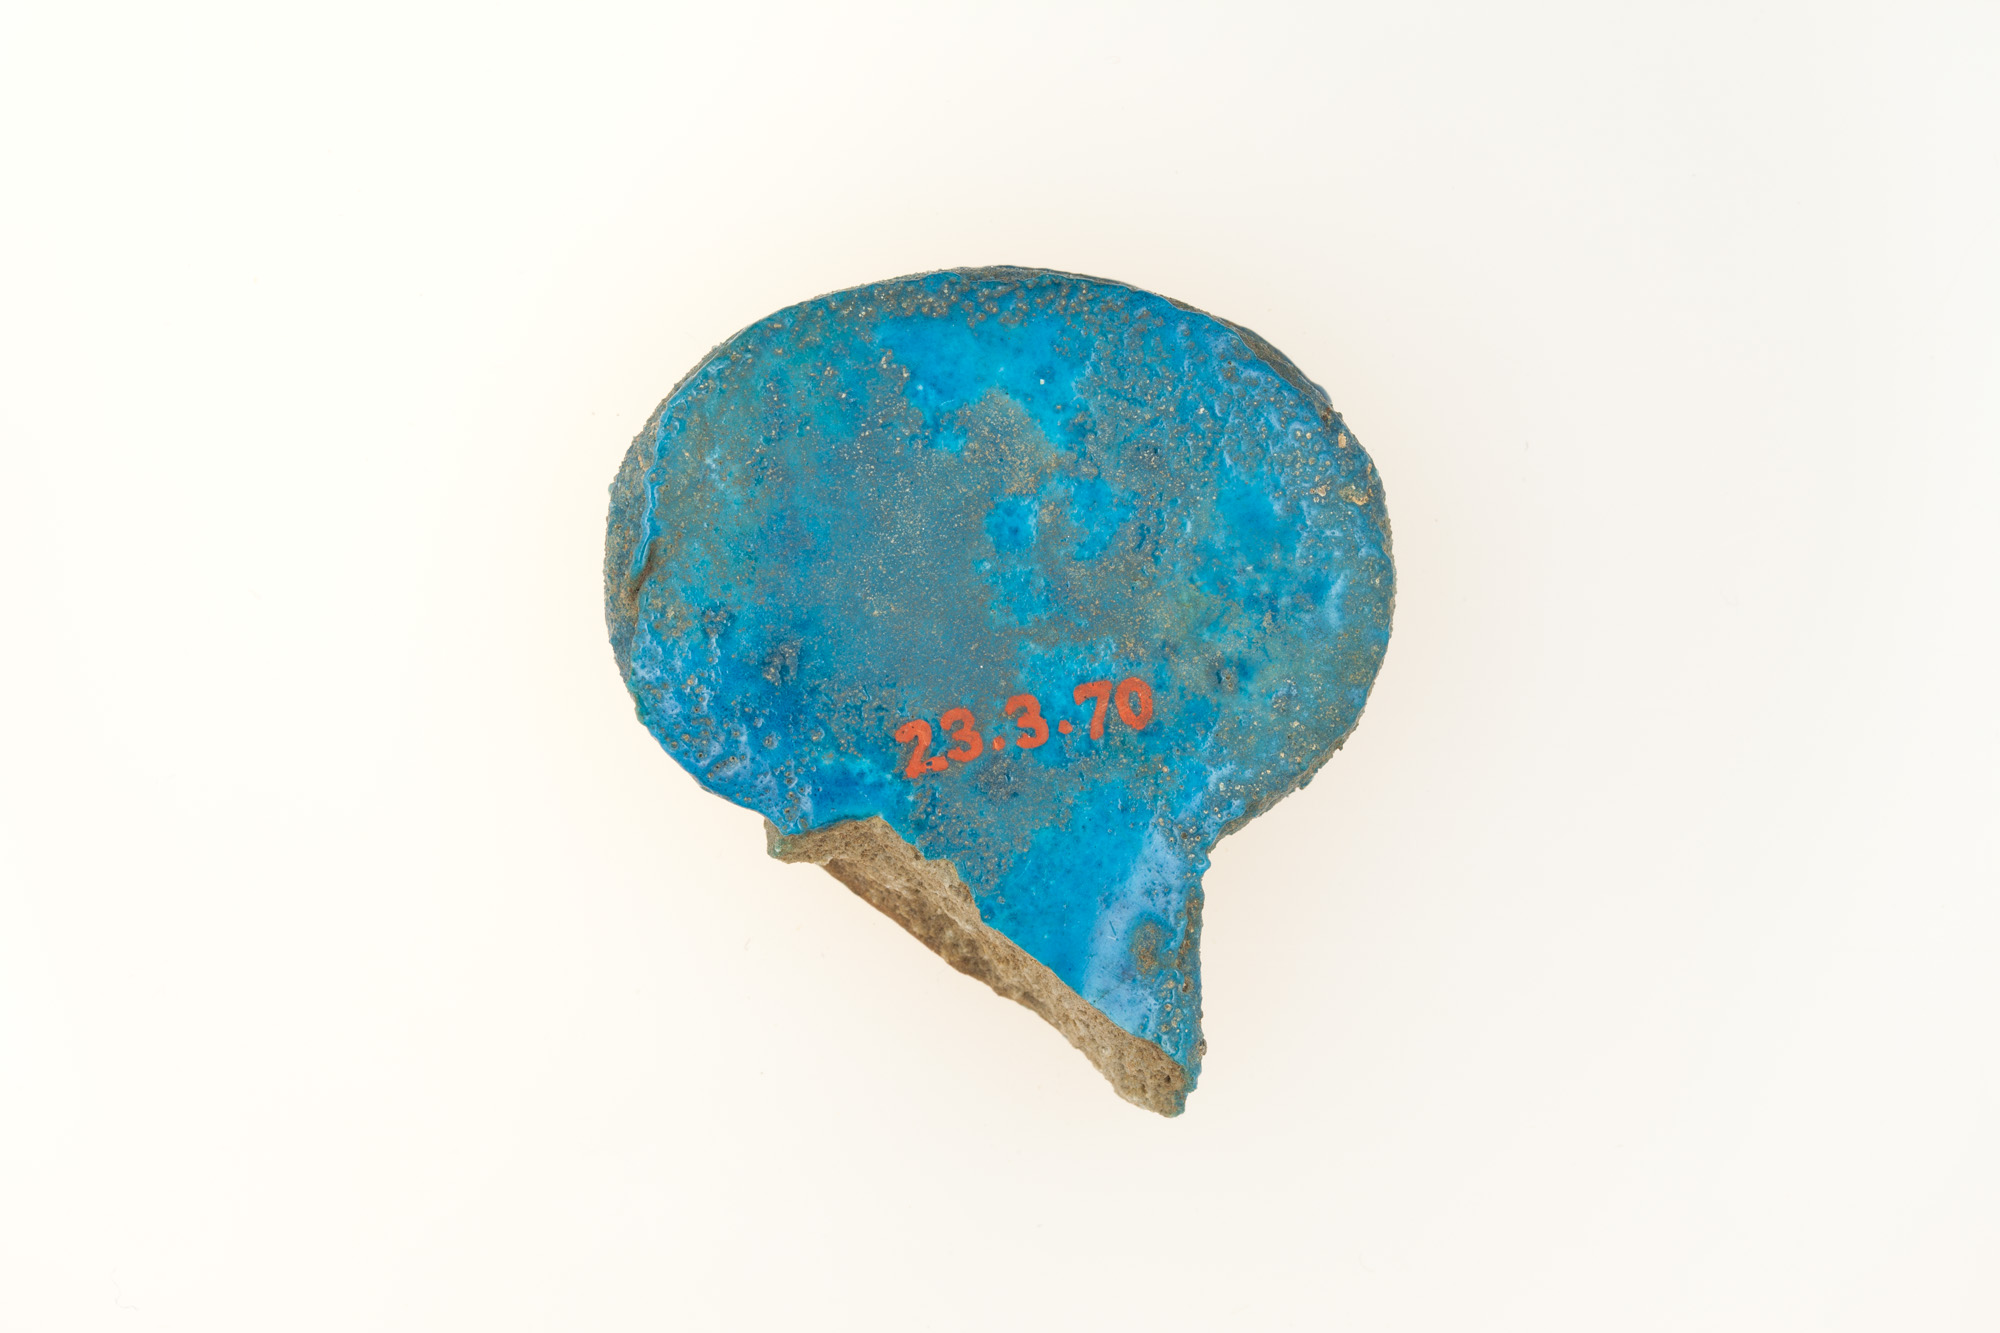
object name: menat fragment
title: Votive Menat fragments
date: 1479-1458 BCE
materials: faience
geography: egypt